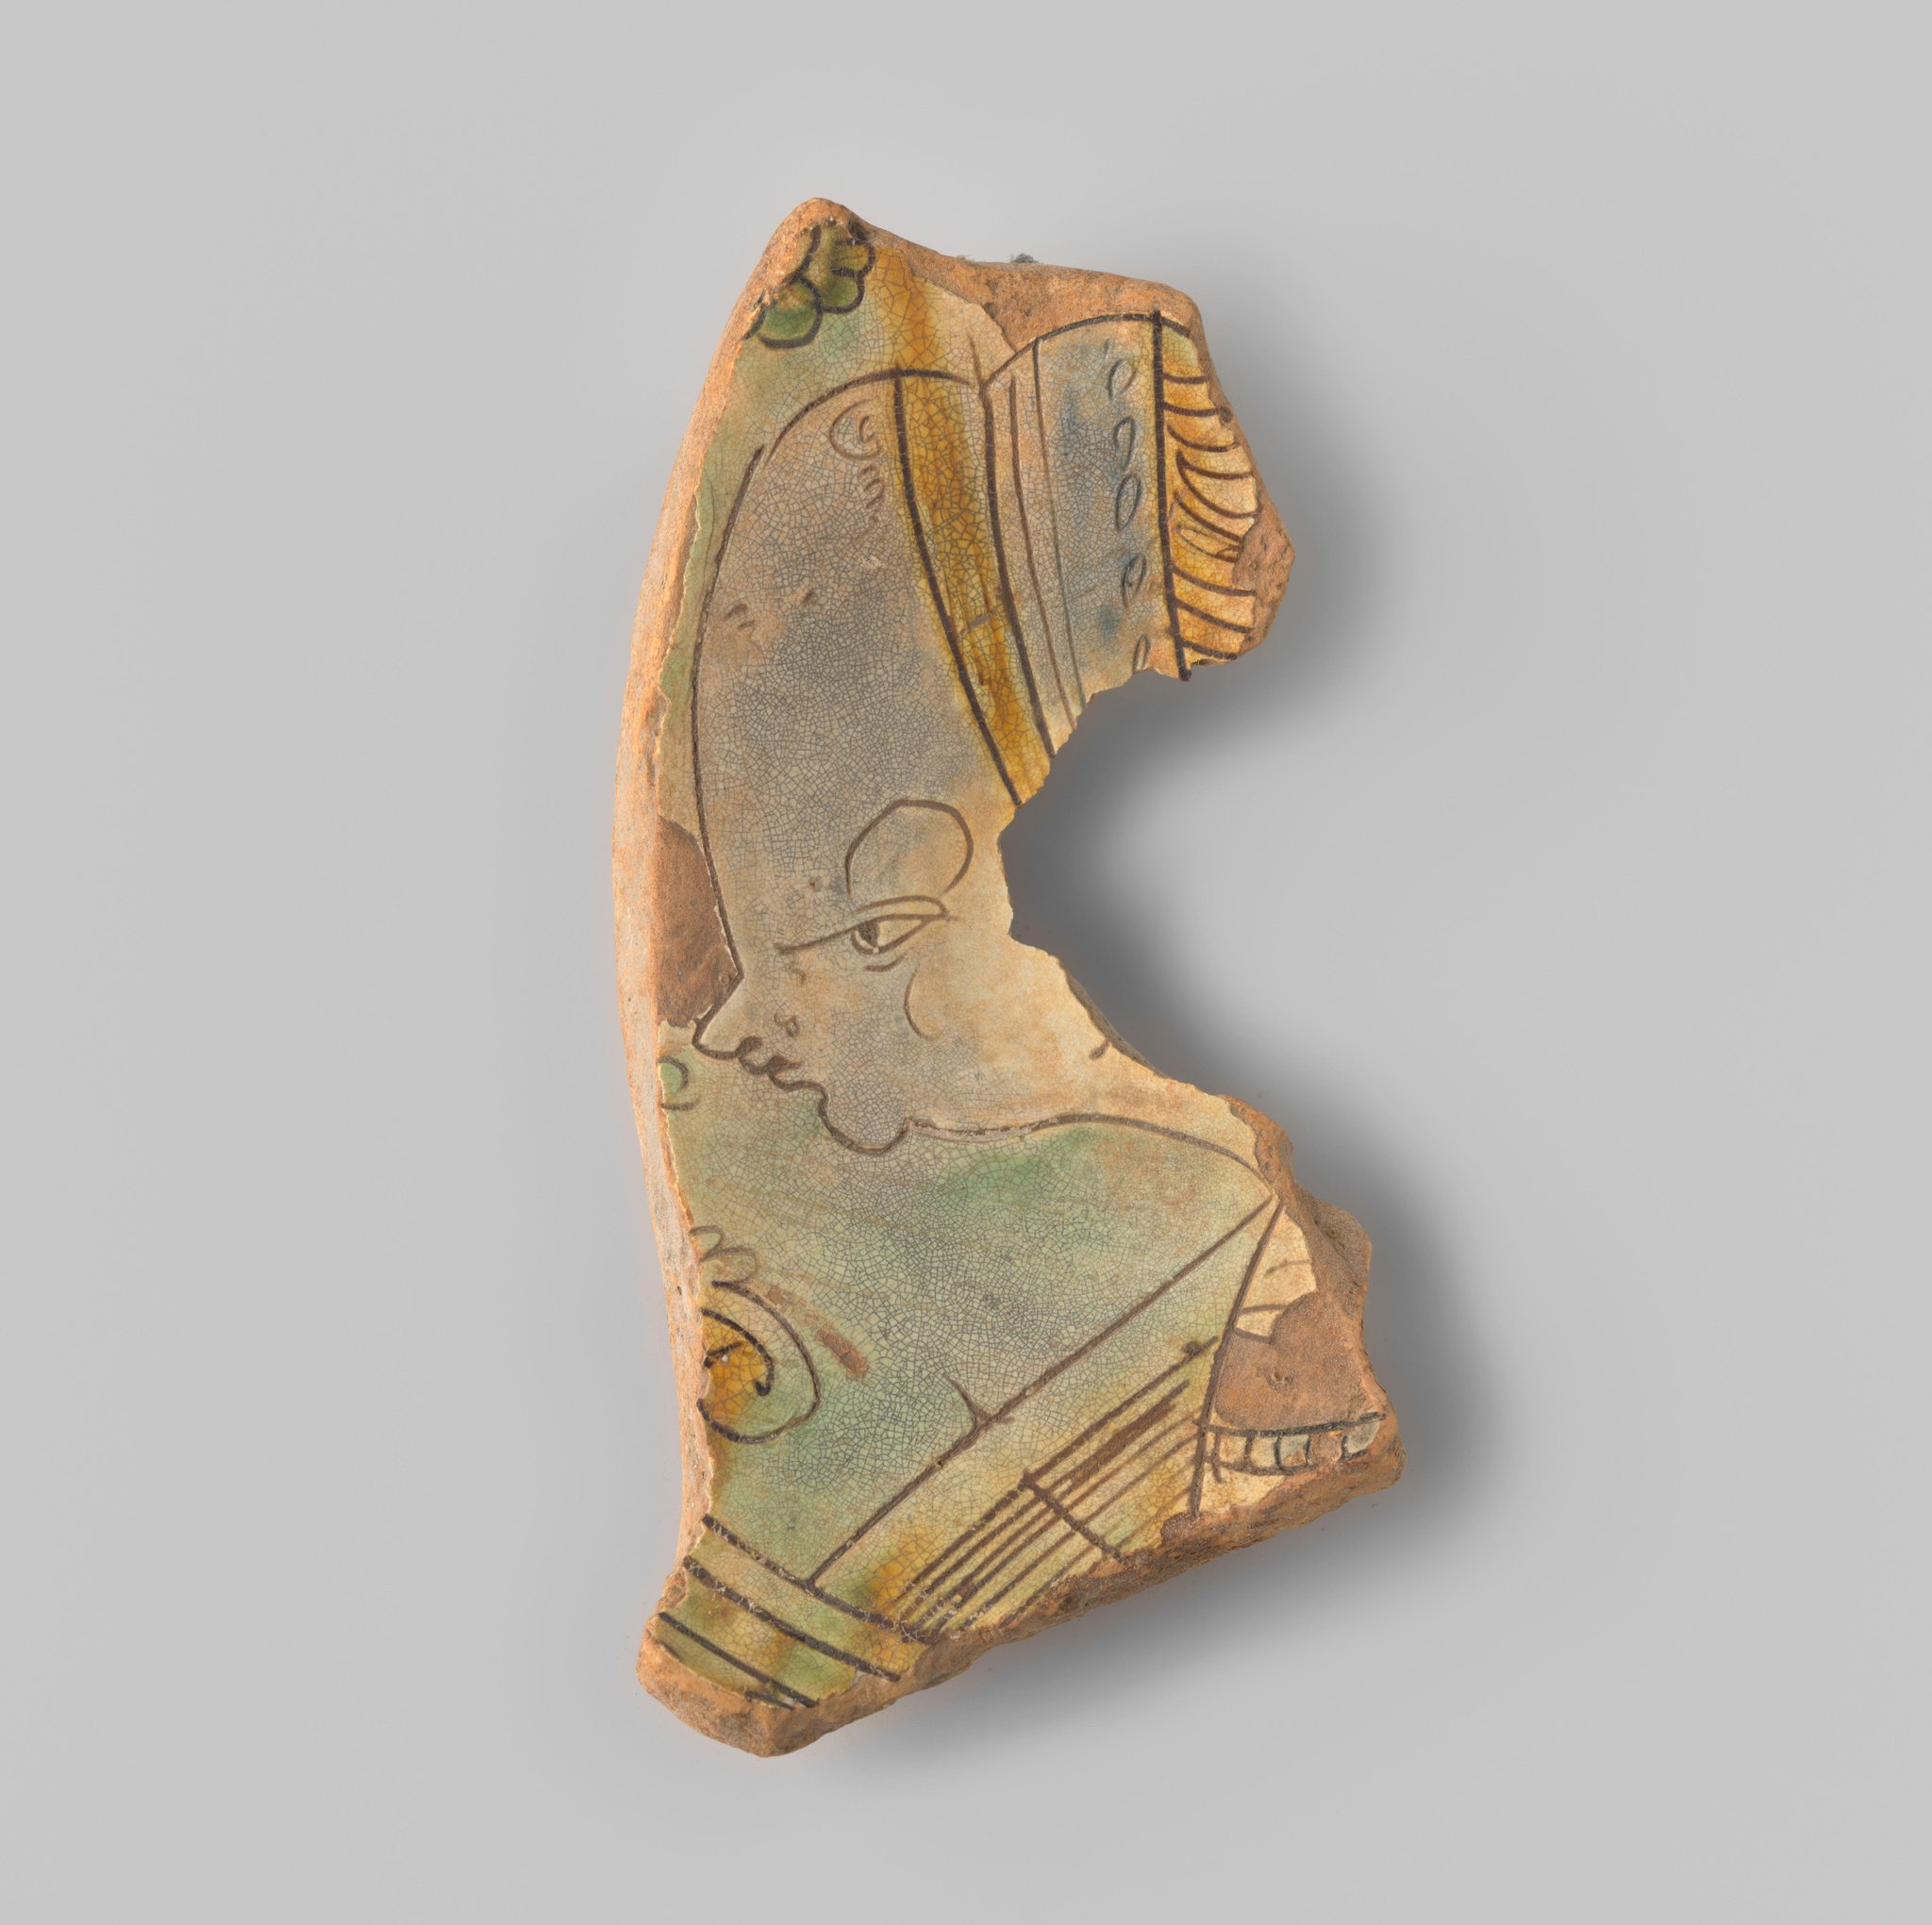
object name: sherd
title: Fragment (voet) van een grote schaal met rode scherf, in sgraffito-techniek een naar links gewend vrouwenborstbeeld, karikatuur met overdreven hoog voorhoofd,in oker, blauw en groen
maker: Anonymous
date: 1200-1899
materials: earthenware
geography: italy